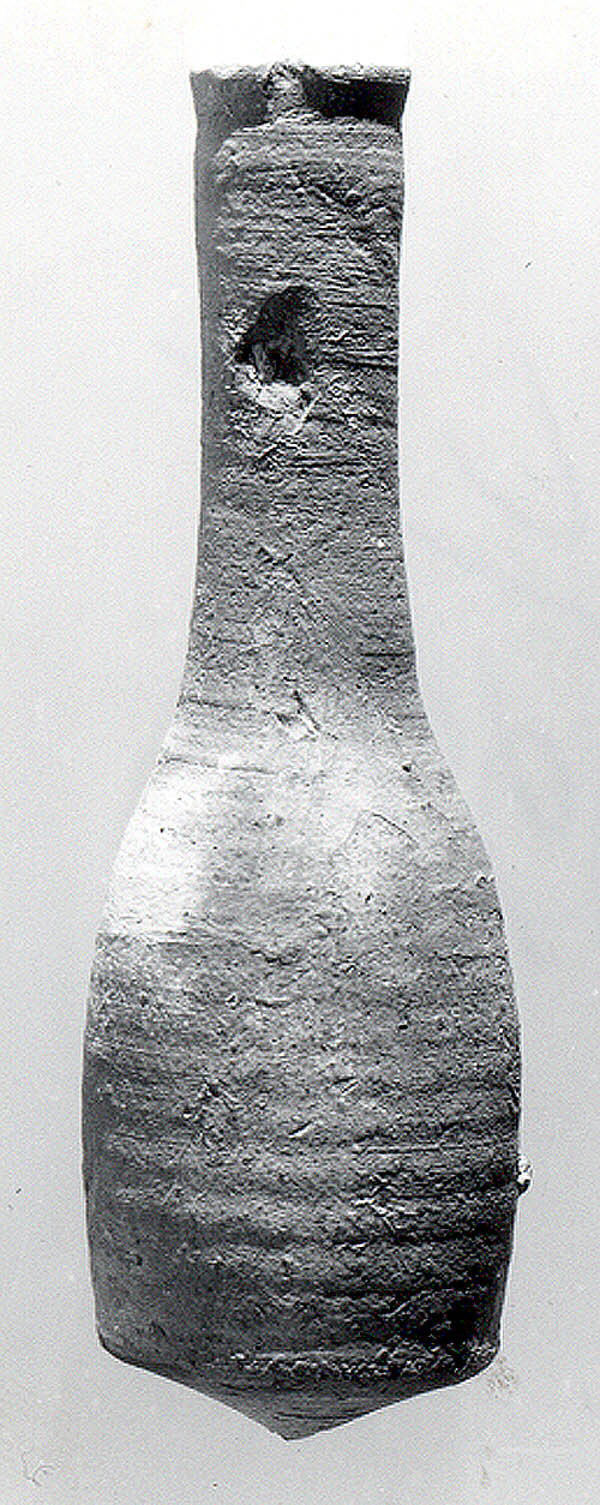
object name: vessel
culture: nabataean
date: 1-100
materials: ceramic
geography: levant